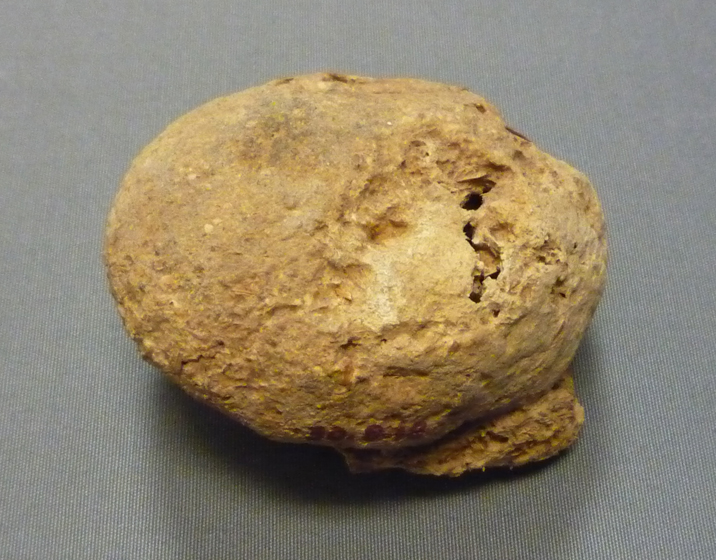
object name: model bread loaf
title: Model Bread Loaf from the Foundation Deposit for Hatshepsut's Tomb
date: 1479-1458 BCE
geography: egypt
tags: bread